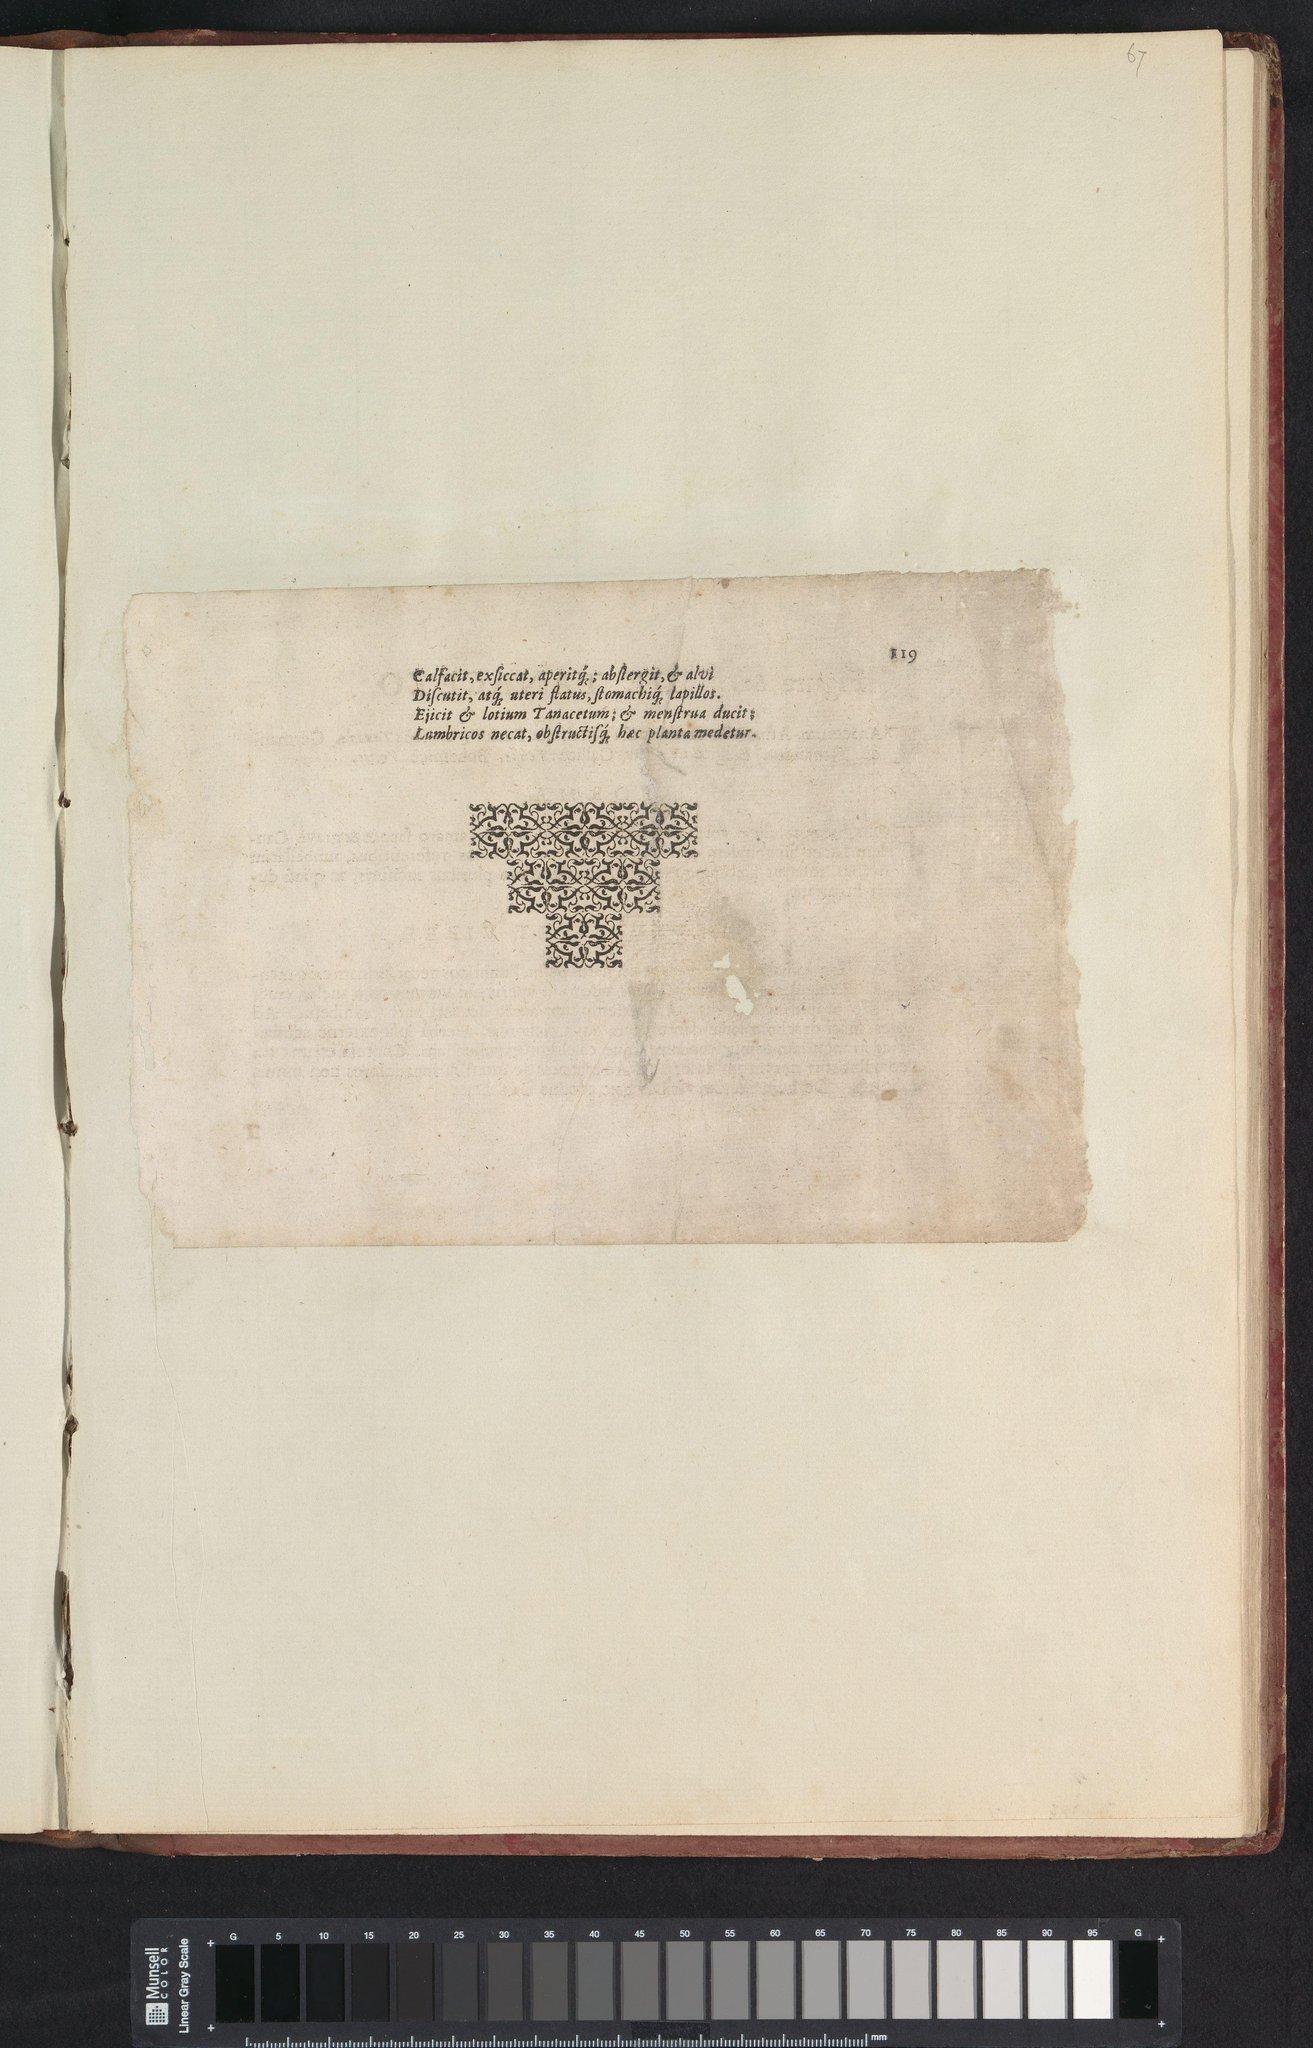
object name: text sheet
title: Fig. 60 'De Tanaceto' in De Boodts herbarium van 1640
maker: anselmus boëtius de boodt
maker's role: draughtsman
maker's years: 1550-1632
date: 1640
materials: ink, paper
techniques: letterpress printing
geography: bruges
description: Beschrijving bij Fig. 60 op p. 119 in: Anselmi Boëtii de Boot I.C. Brugensis & Rodolphi II. Imp. Roman. medici a cubiculis Florum, Herbarum, ac fructuum selectiorum icones, & vires pleraeque hactenus ignotæ. Onderdeel van het album met bladen en platen uit De Boodts herbarium van 1640. Het twaalfde van twaalf albums met aquarellen van dieren, vogels en planten bekend rond 1600, gemaakt in opdracht van keizer Rudolf II.